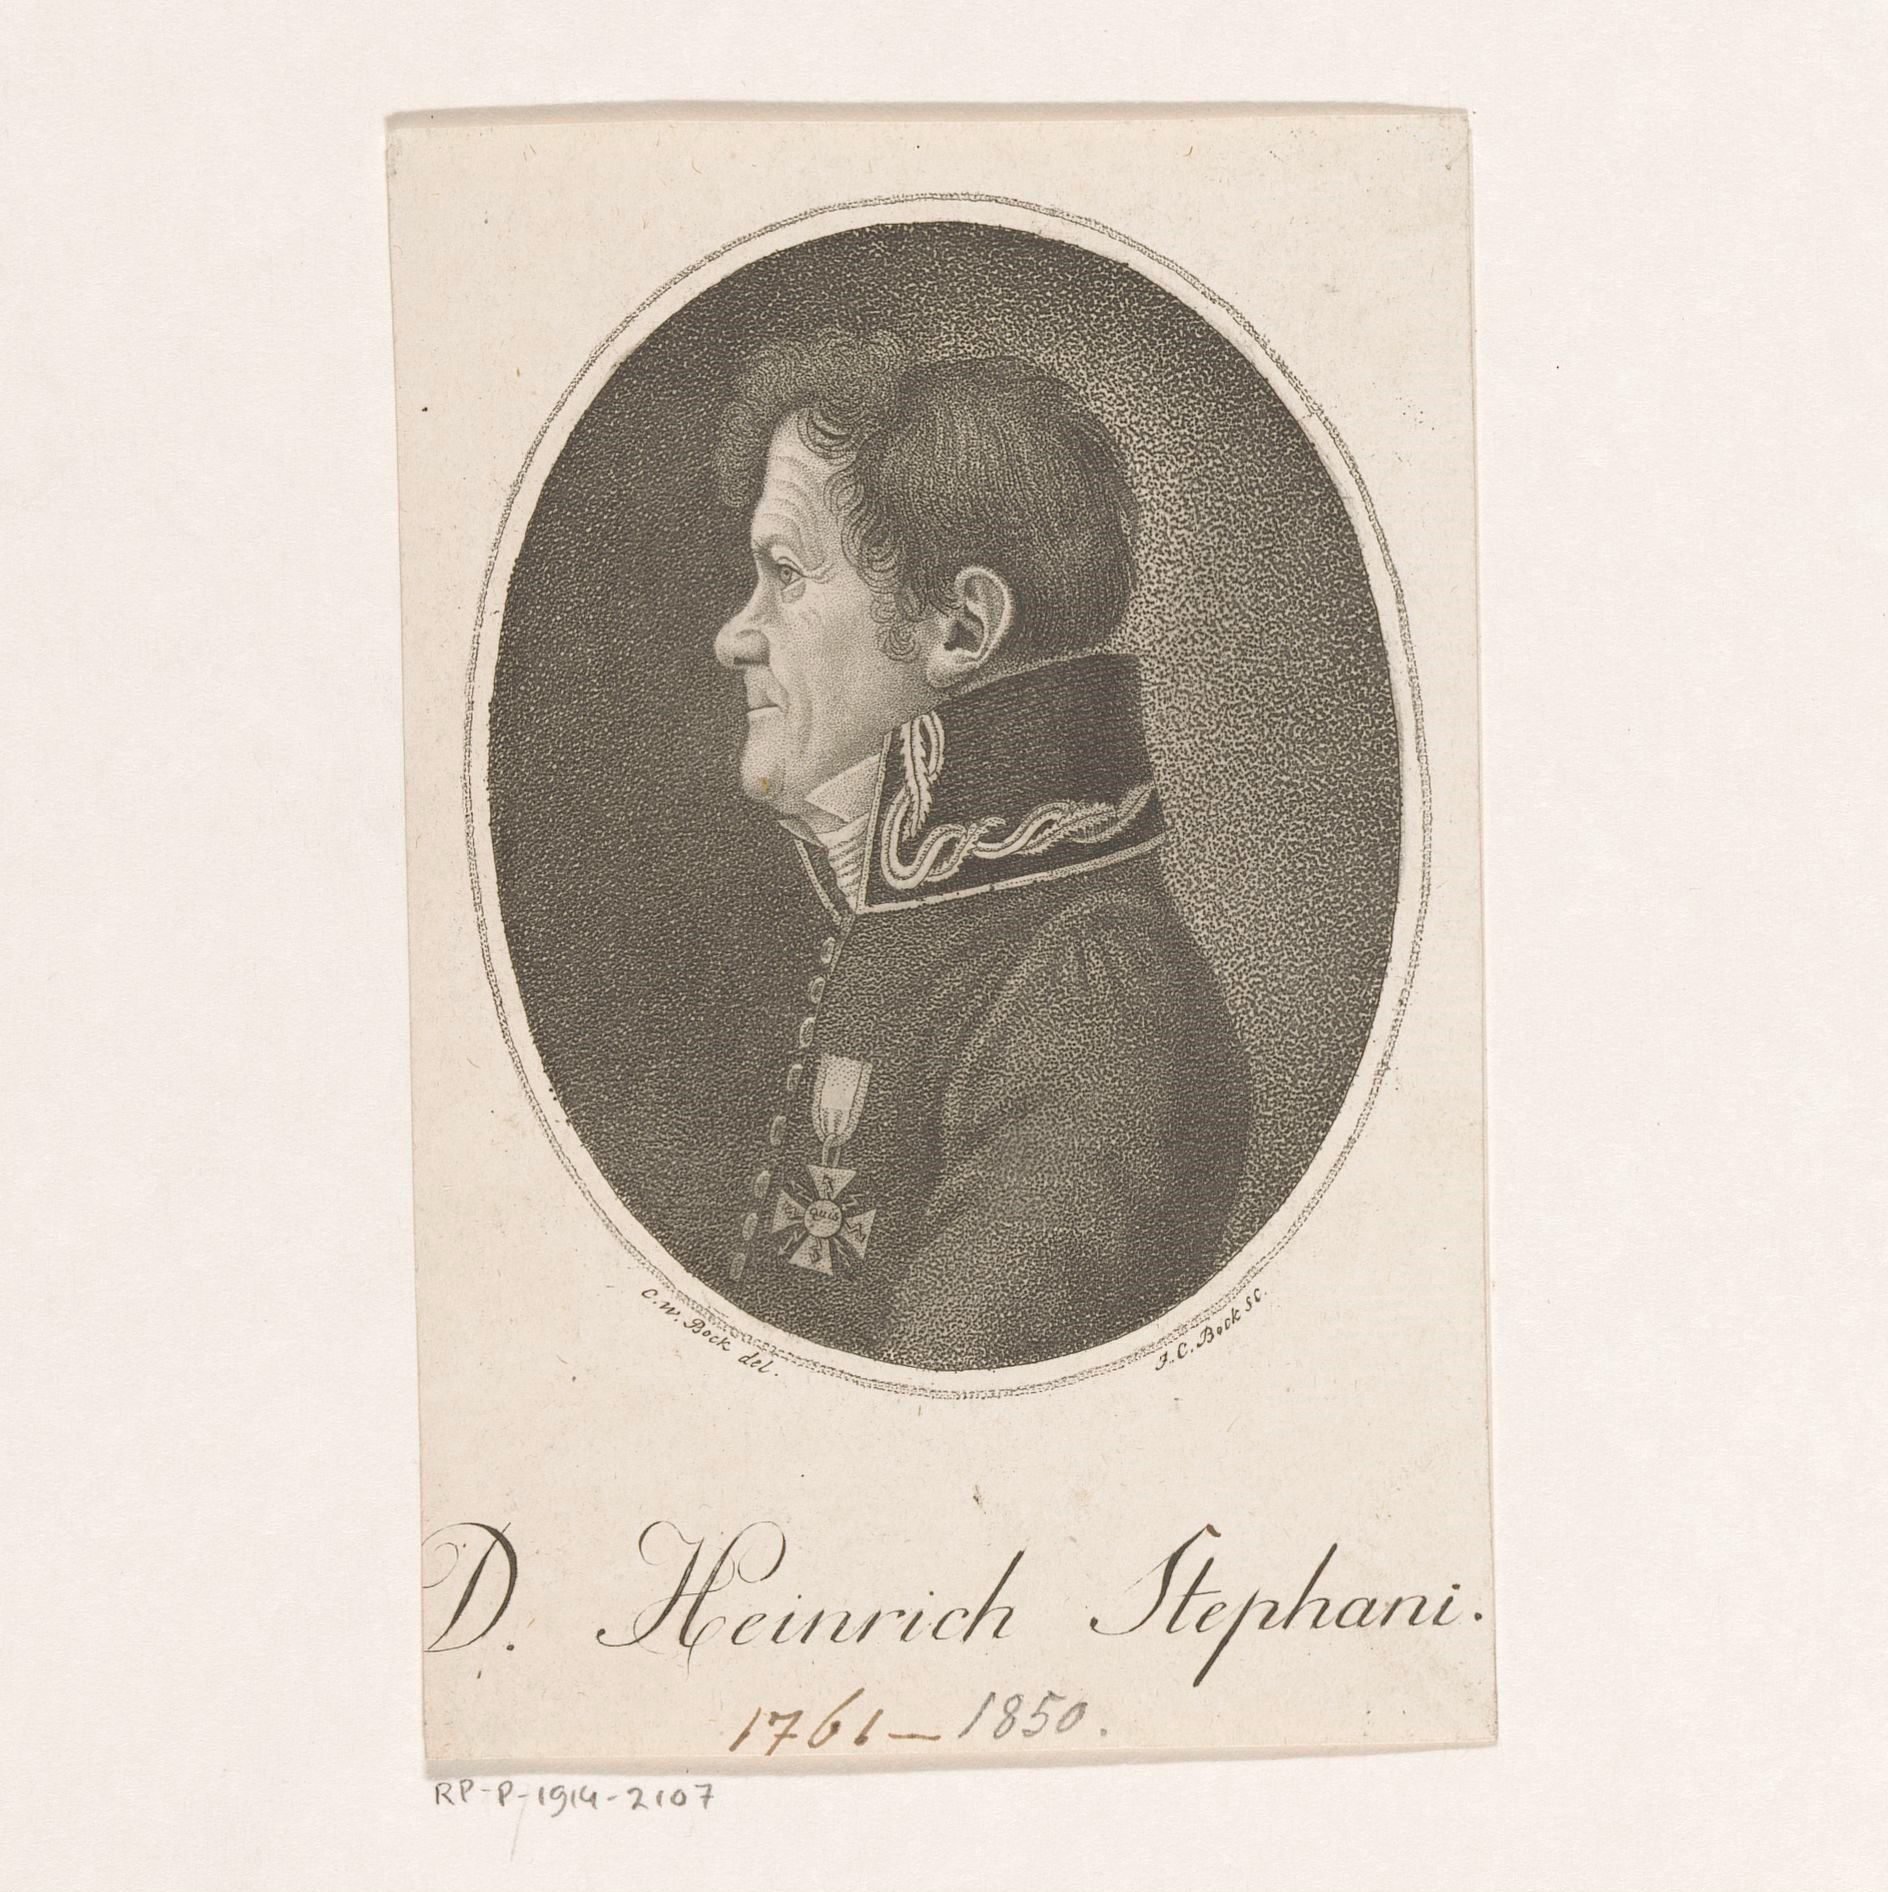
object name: print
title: Portret van Heinrich Stephani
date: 1780-1843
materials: paper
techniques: etching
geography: nuremberg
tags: knighthood order, historical persons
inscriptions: collector's mark: Lugt 2228